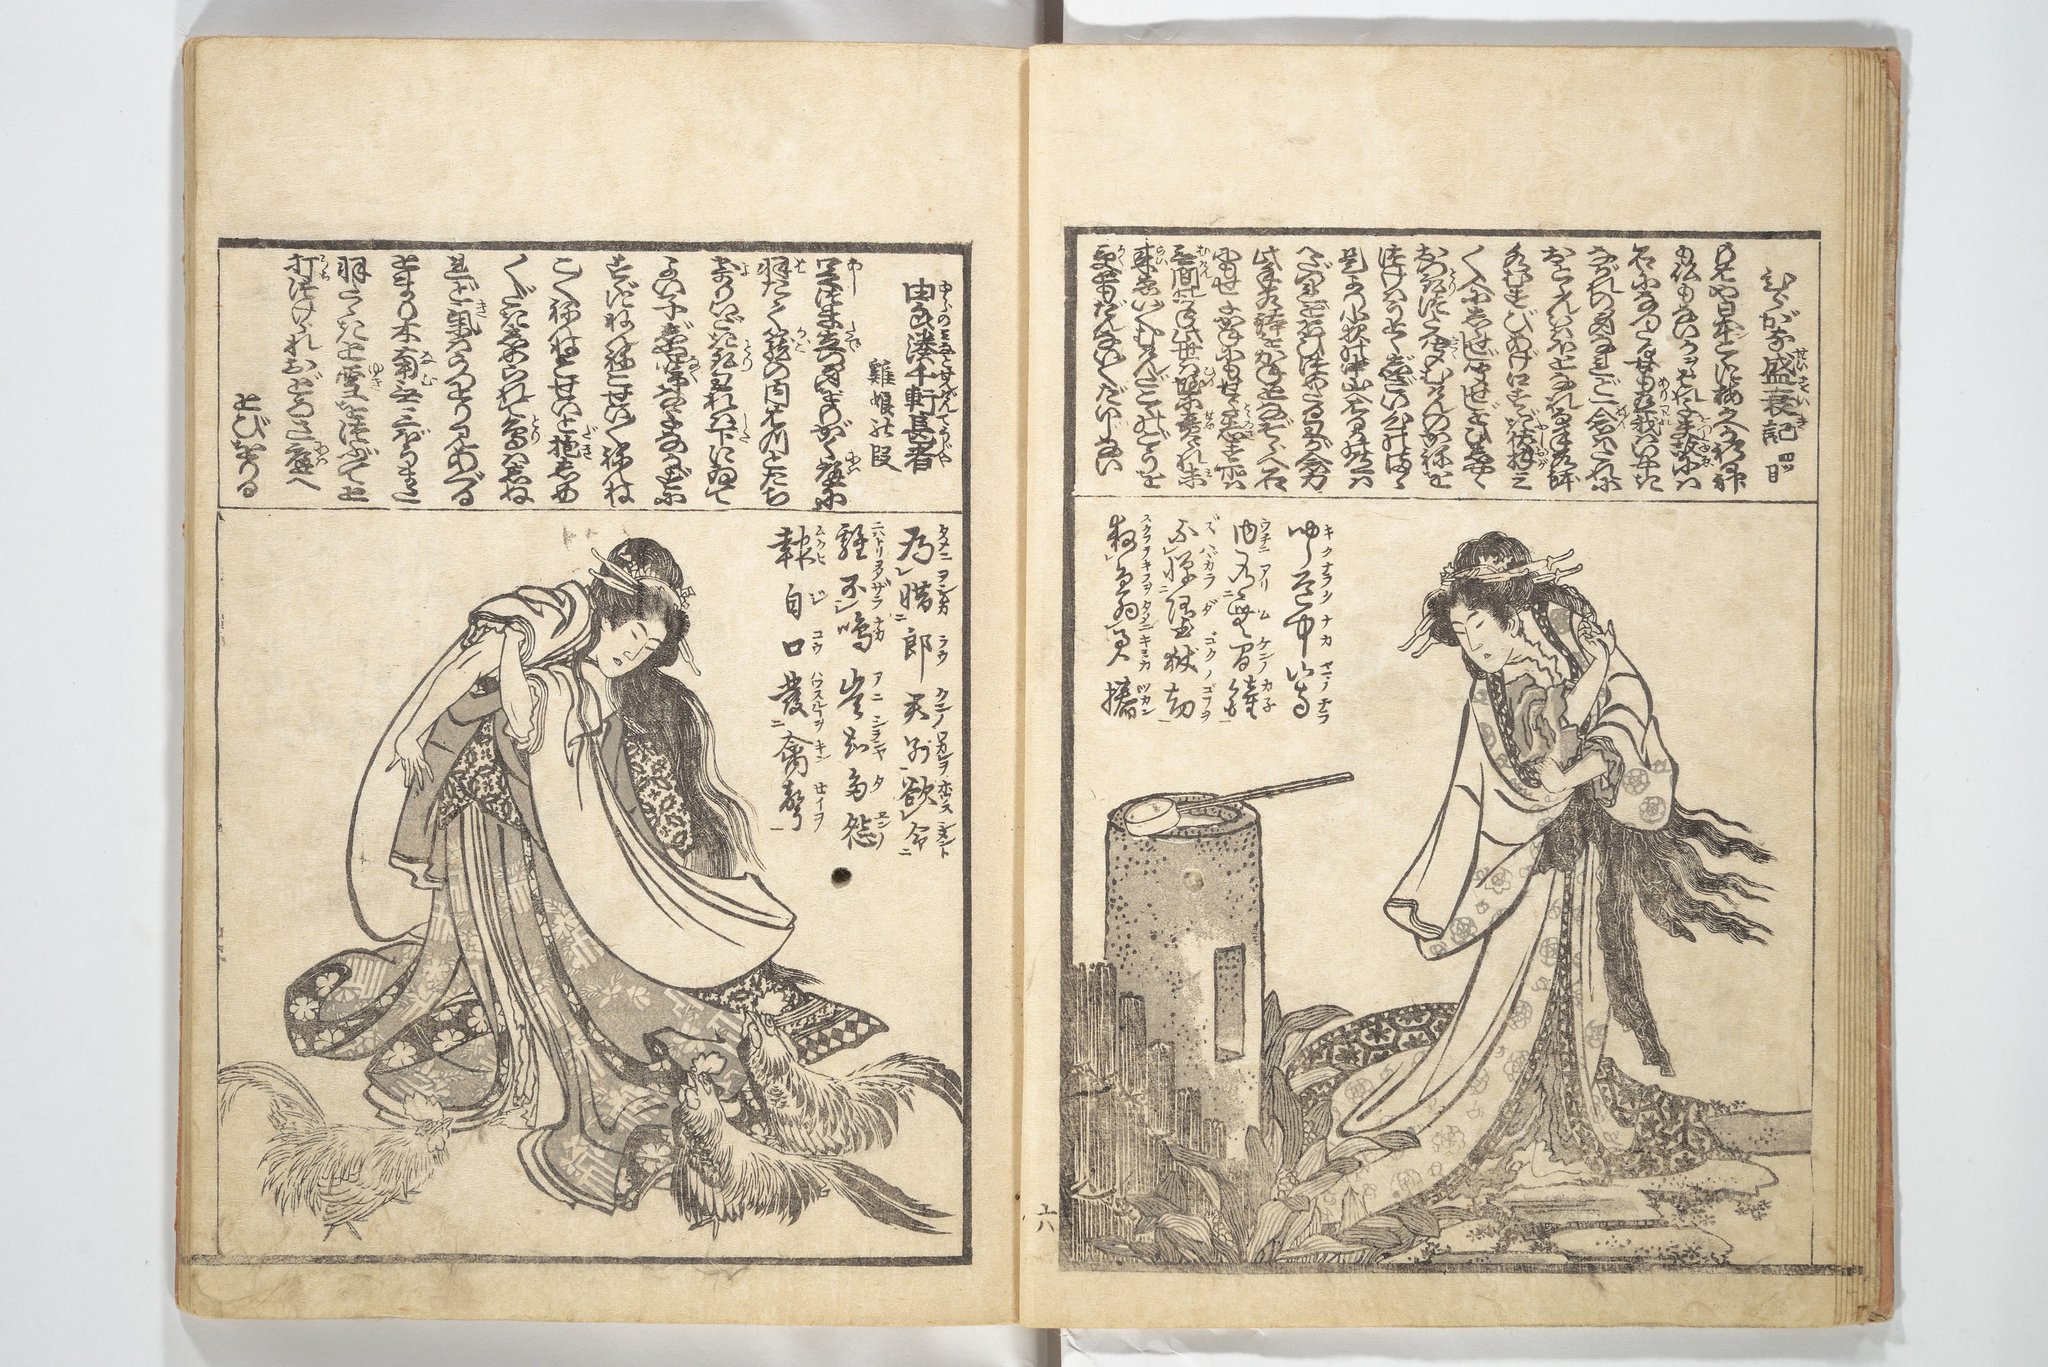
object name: illustrated book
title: Mixed Verses on Jōruri (Puppet Theater) (Ehon jōruri zekku) 画本浄瑠璃絶句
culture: japanese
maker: katsushika hokusai 葛飾北斎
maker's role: artist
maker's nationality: japanese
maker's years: 1760-1849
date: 1815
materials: ink, paper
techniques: woodblock print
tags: men,women,roosters